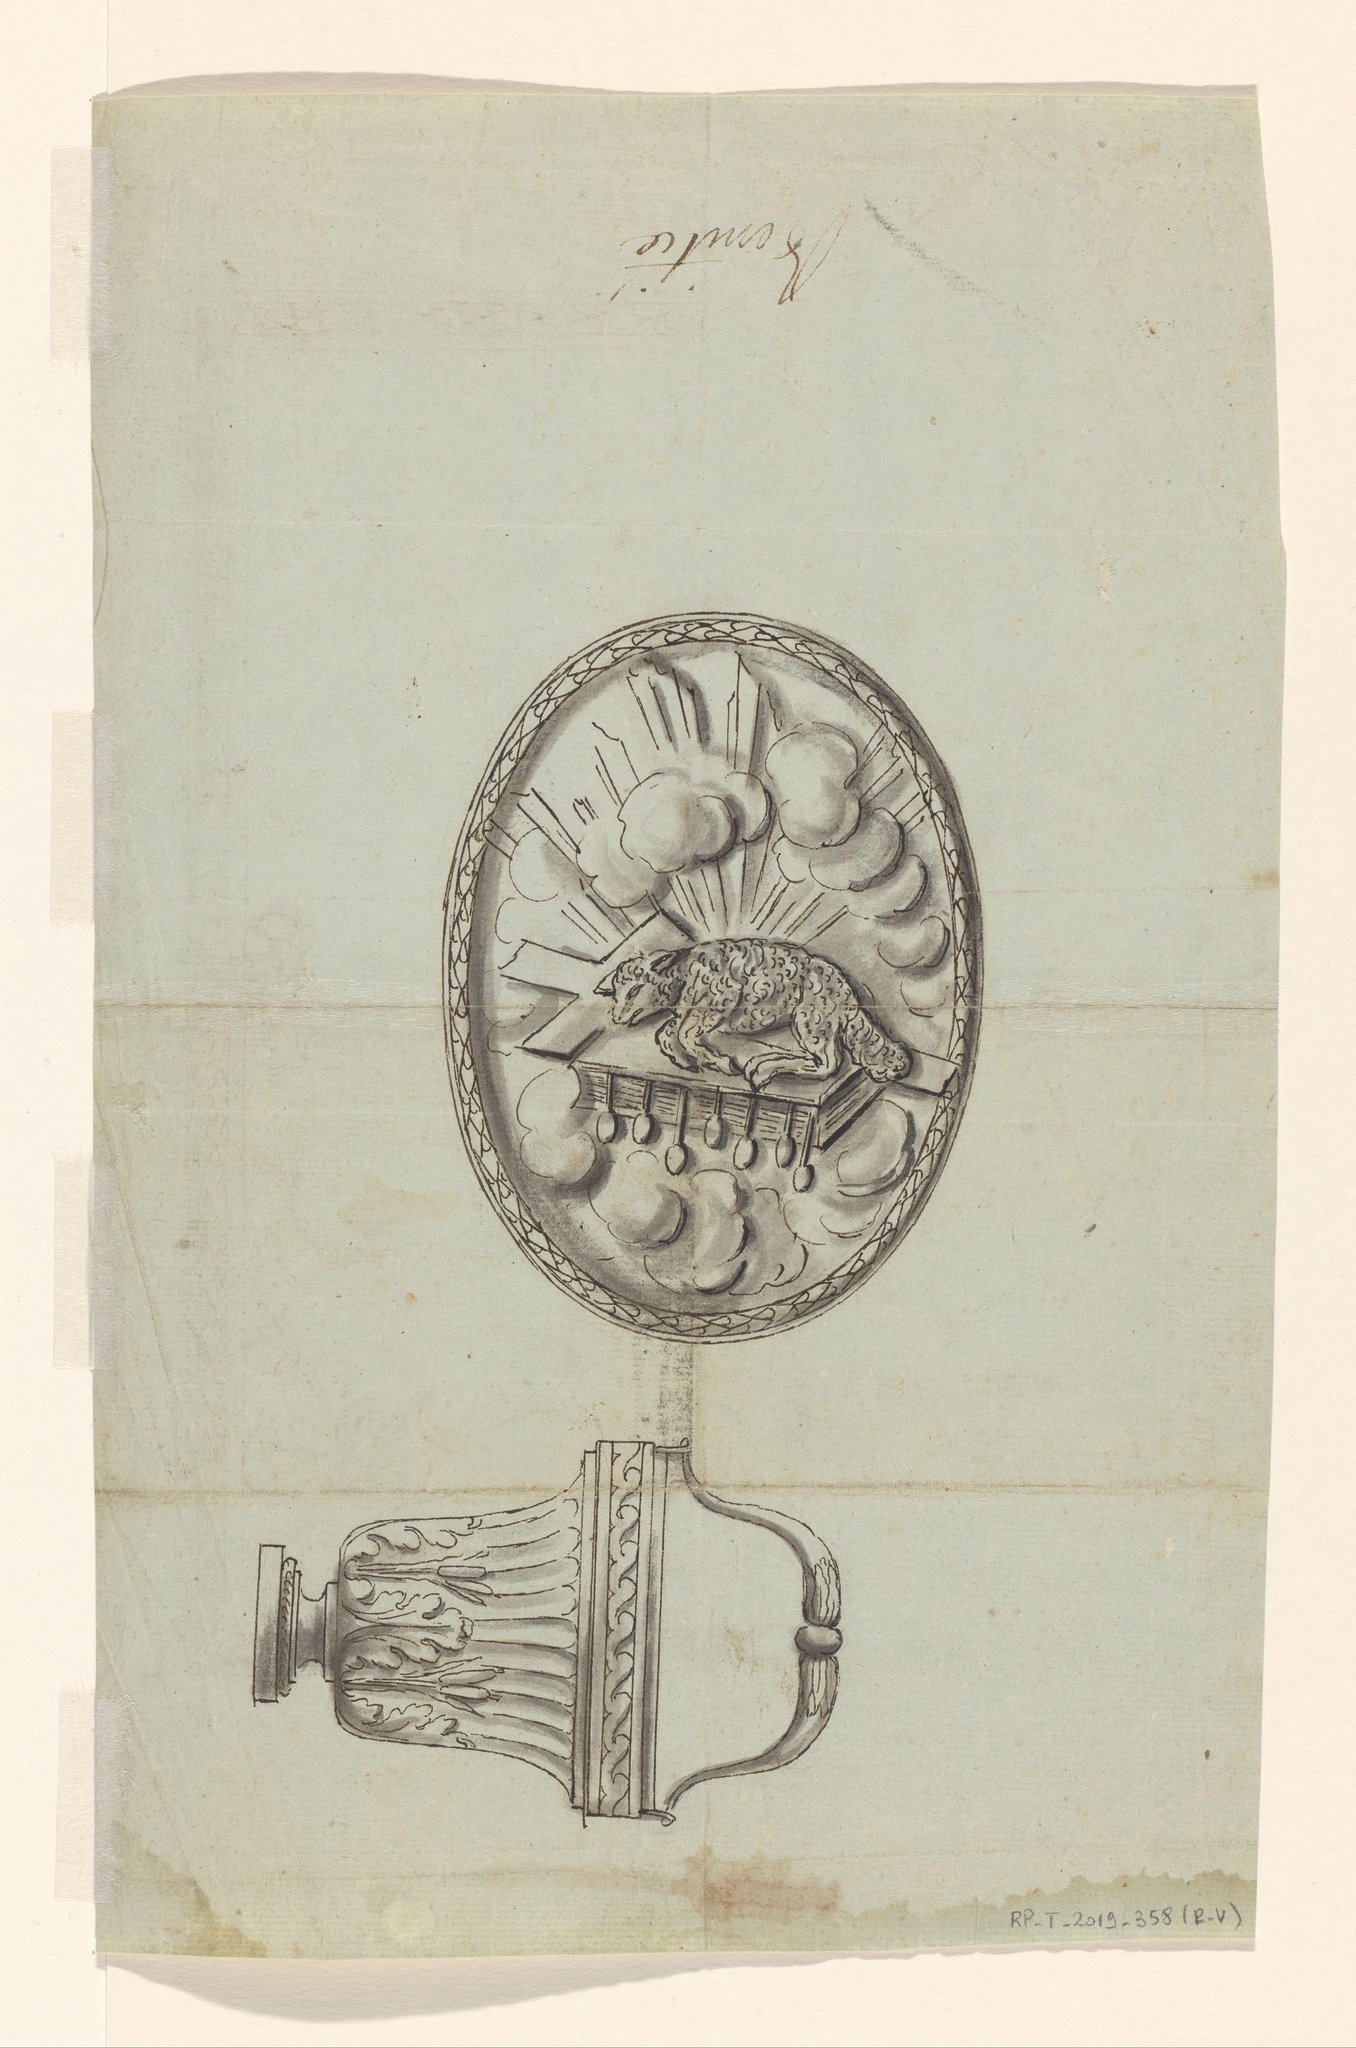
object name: design drawing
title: Medaillon met het lam op het boek met de zeven zegels, en ontwerp voor een wijwatervat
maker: Anonymous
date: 1780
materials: graphite, ink, paper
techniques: brush, pen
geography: paris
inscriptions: inscription: ‘Benitié’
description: Variant op de bovenste helft van 20. Hier is de voorstelling van de hemelvaart van Maria niet in een andere hand. Door spijker samengevoegd met RP-T-2019-356.